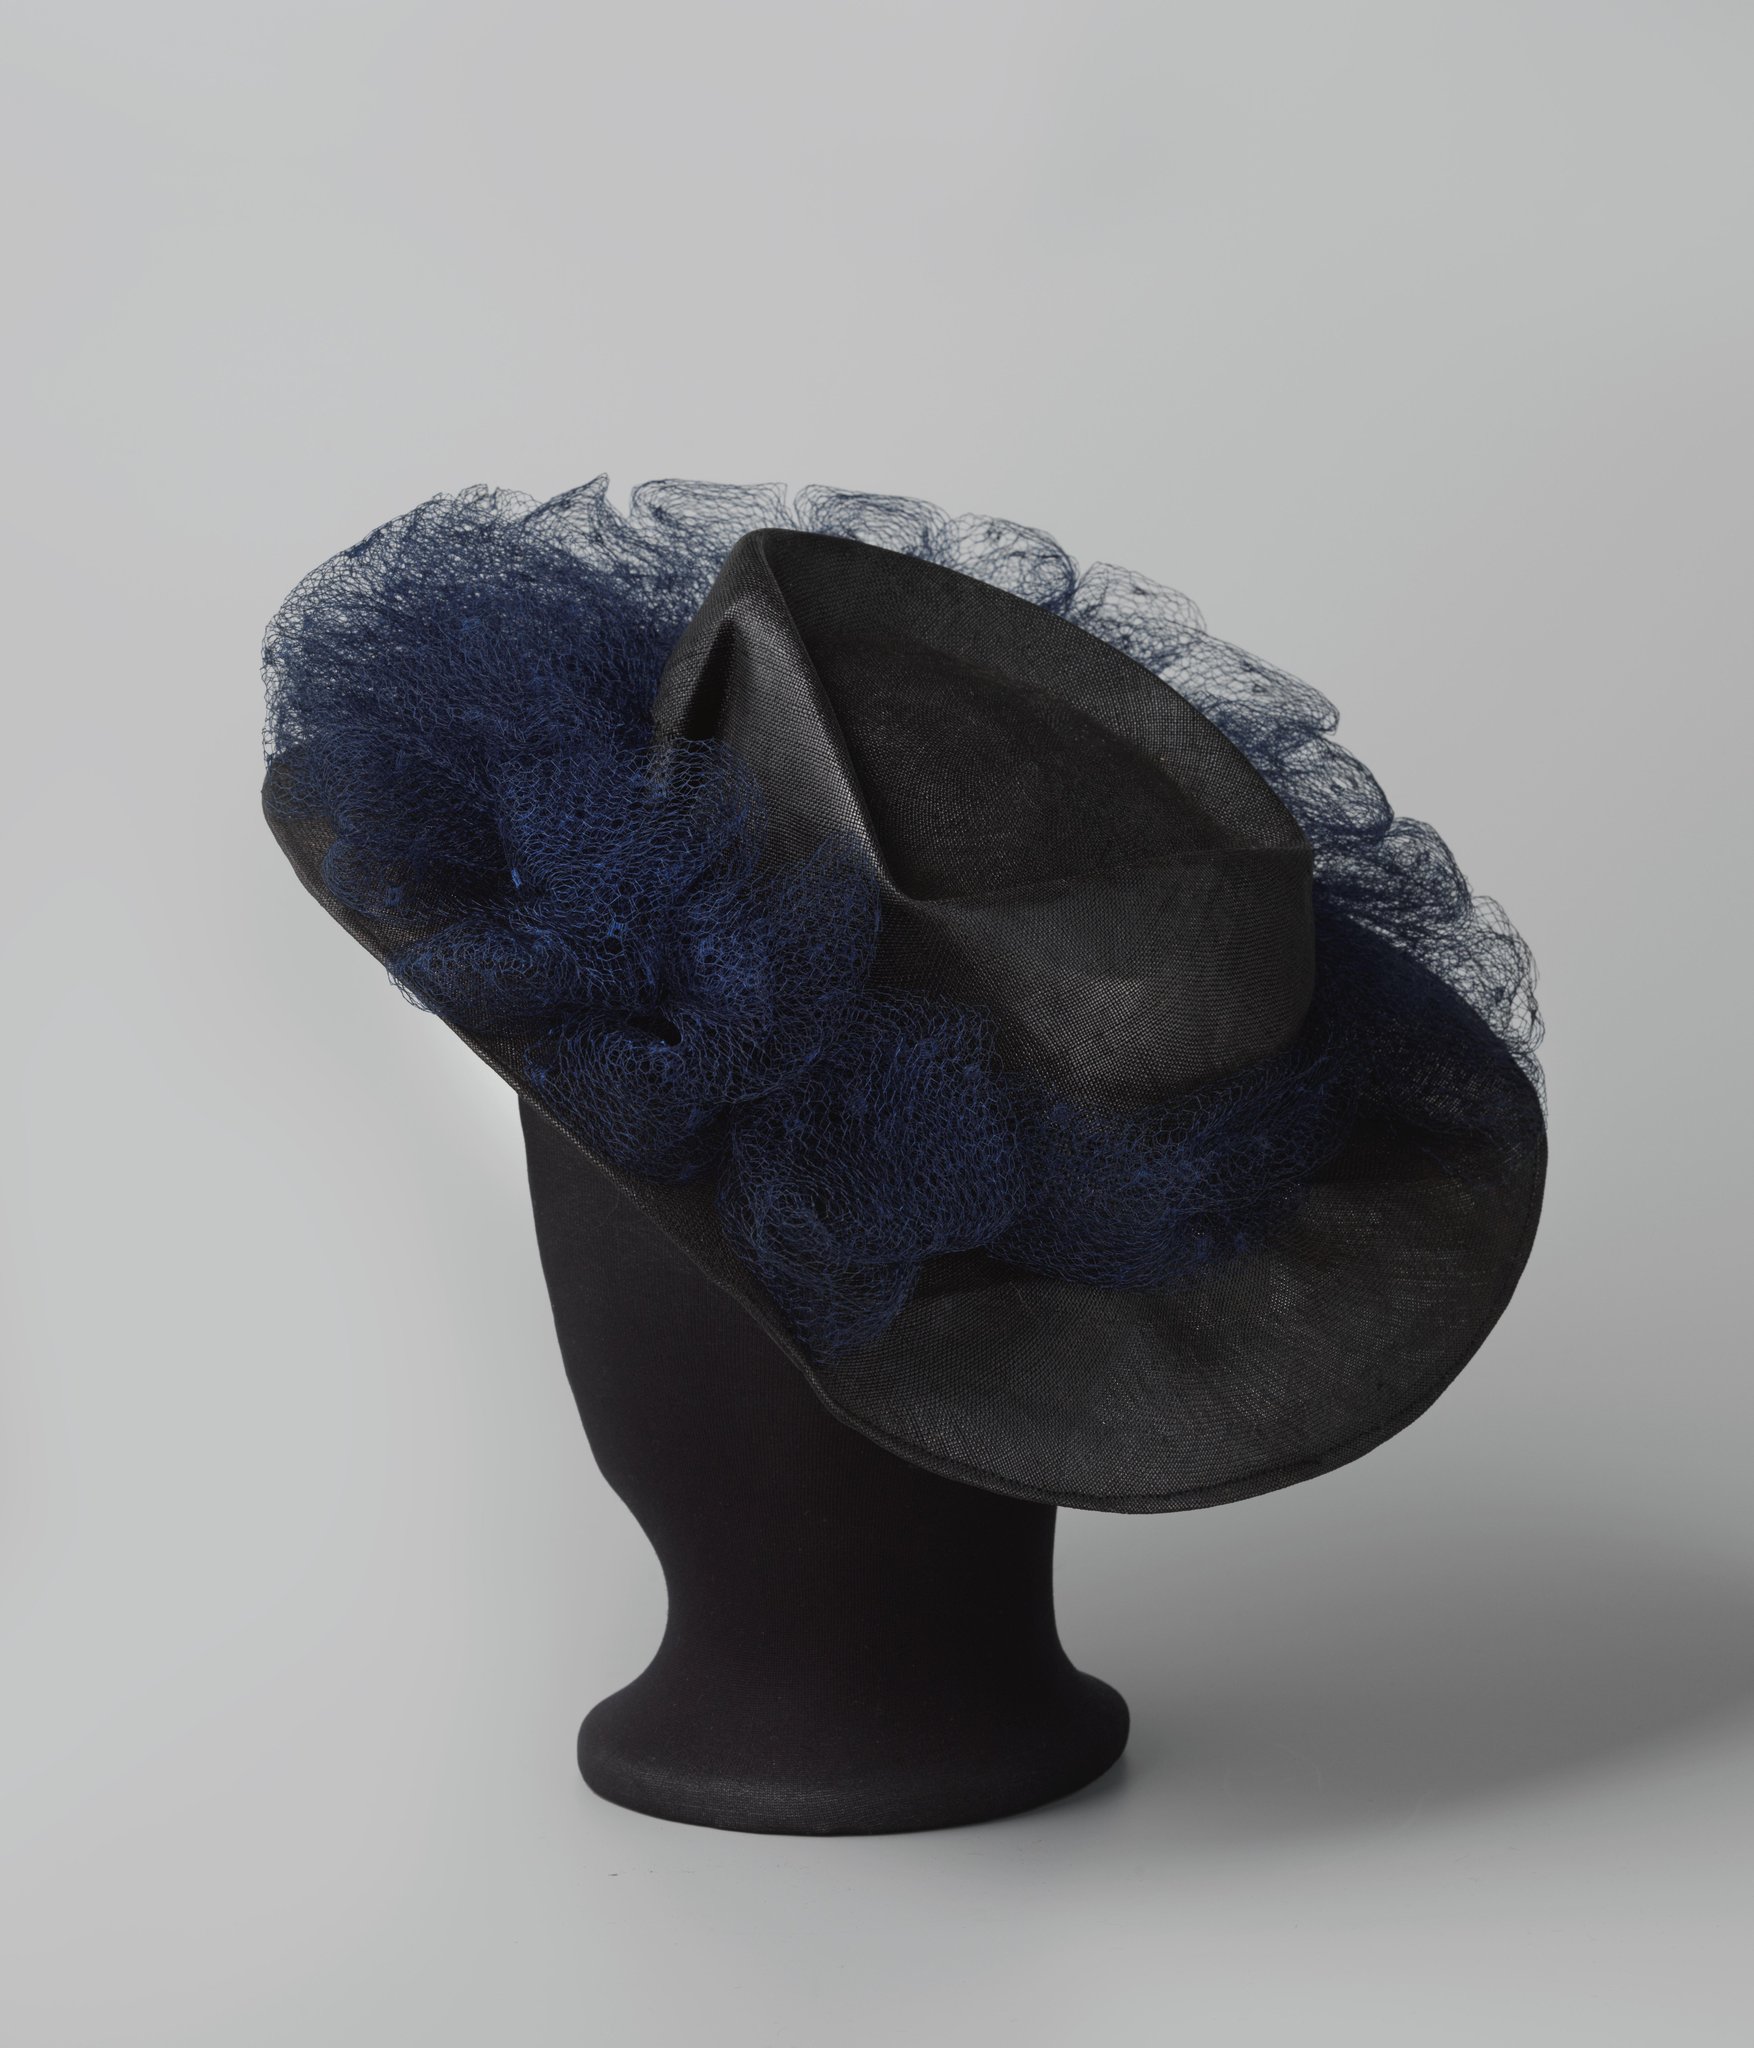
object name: womenswear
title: Hoed van donkerblauwe stro en blauw tule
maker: t.c.c.m. hoogland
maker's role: hoedenmaker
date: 1950-1955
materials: straw, fiber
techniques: strohalm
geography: utrecht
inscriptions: label: ‘T.C.C.M. Hoogland // UTRECHT’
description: Dameshoed van donkerblauw stroo met blauwe tulle. Model: Driehoekige vouw in de bol. Voorover hellende brede rand. Versiering: rondom ligt op de rand een ruche van stijve tulle, met vage nopjes. Adres: T.C. C. M. Hoogland, UTRCHT. Toestand: Als nieuw.